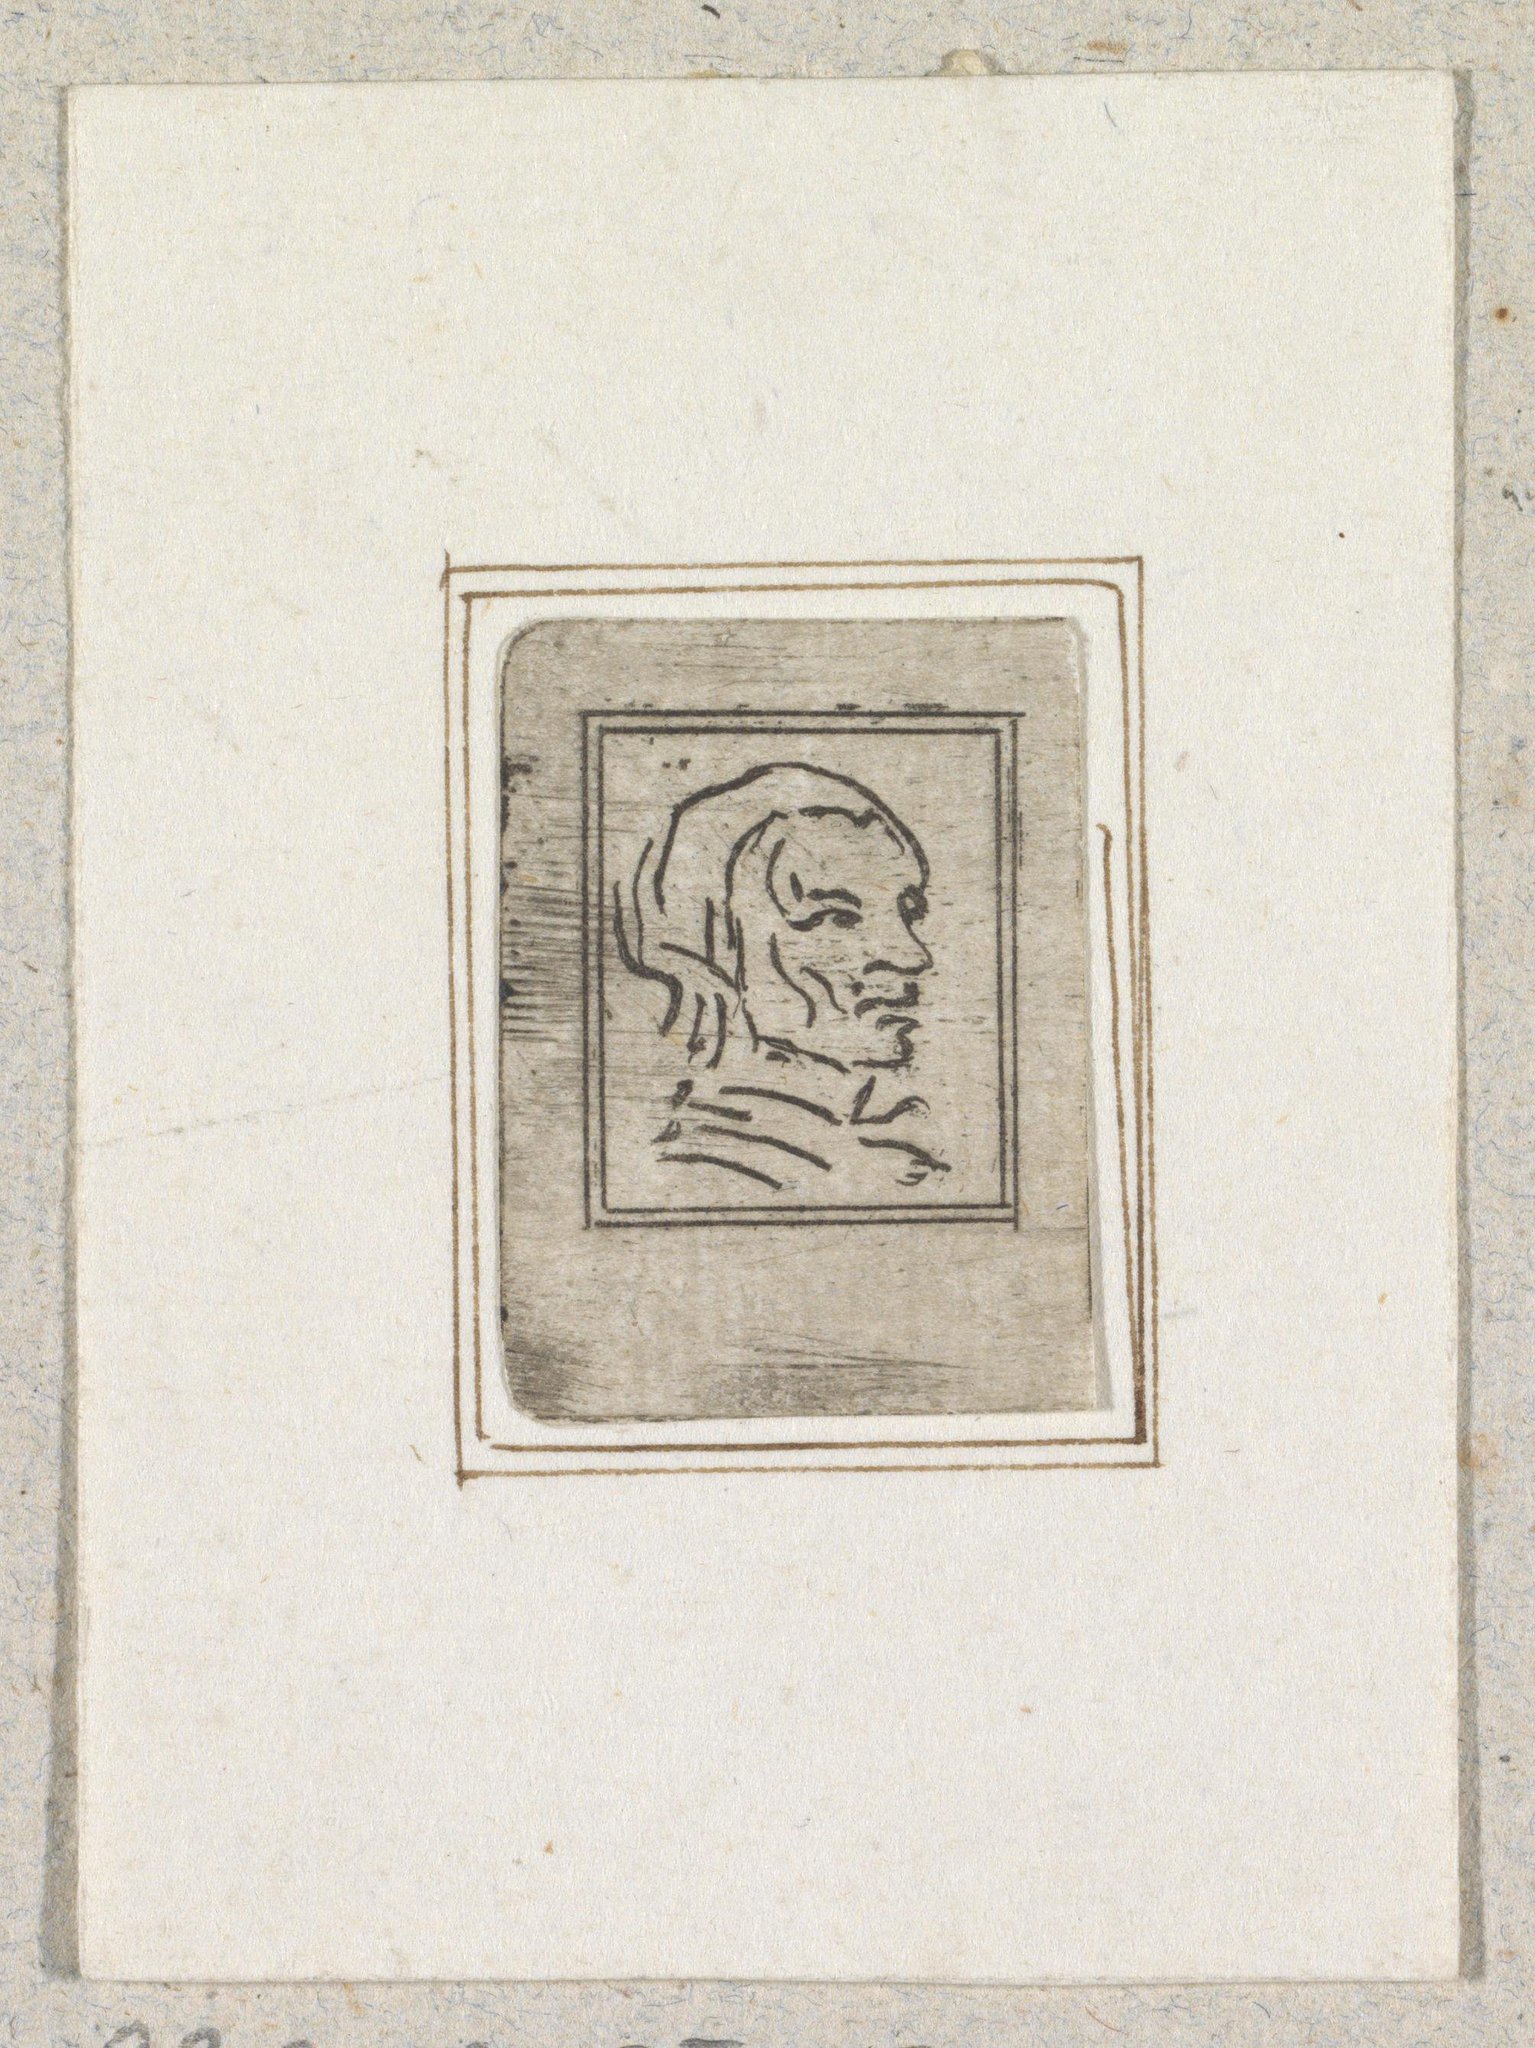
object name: print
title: Gezicht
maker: Anonymous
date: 1700-1900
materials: paper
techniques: etching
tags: face